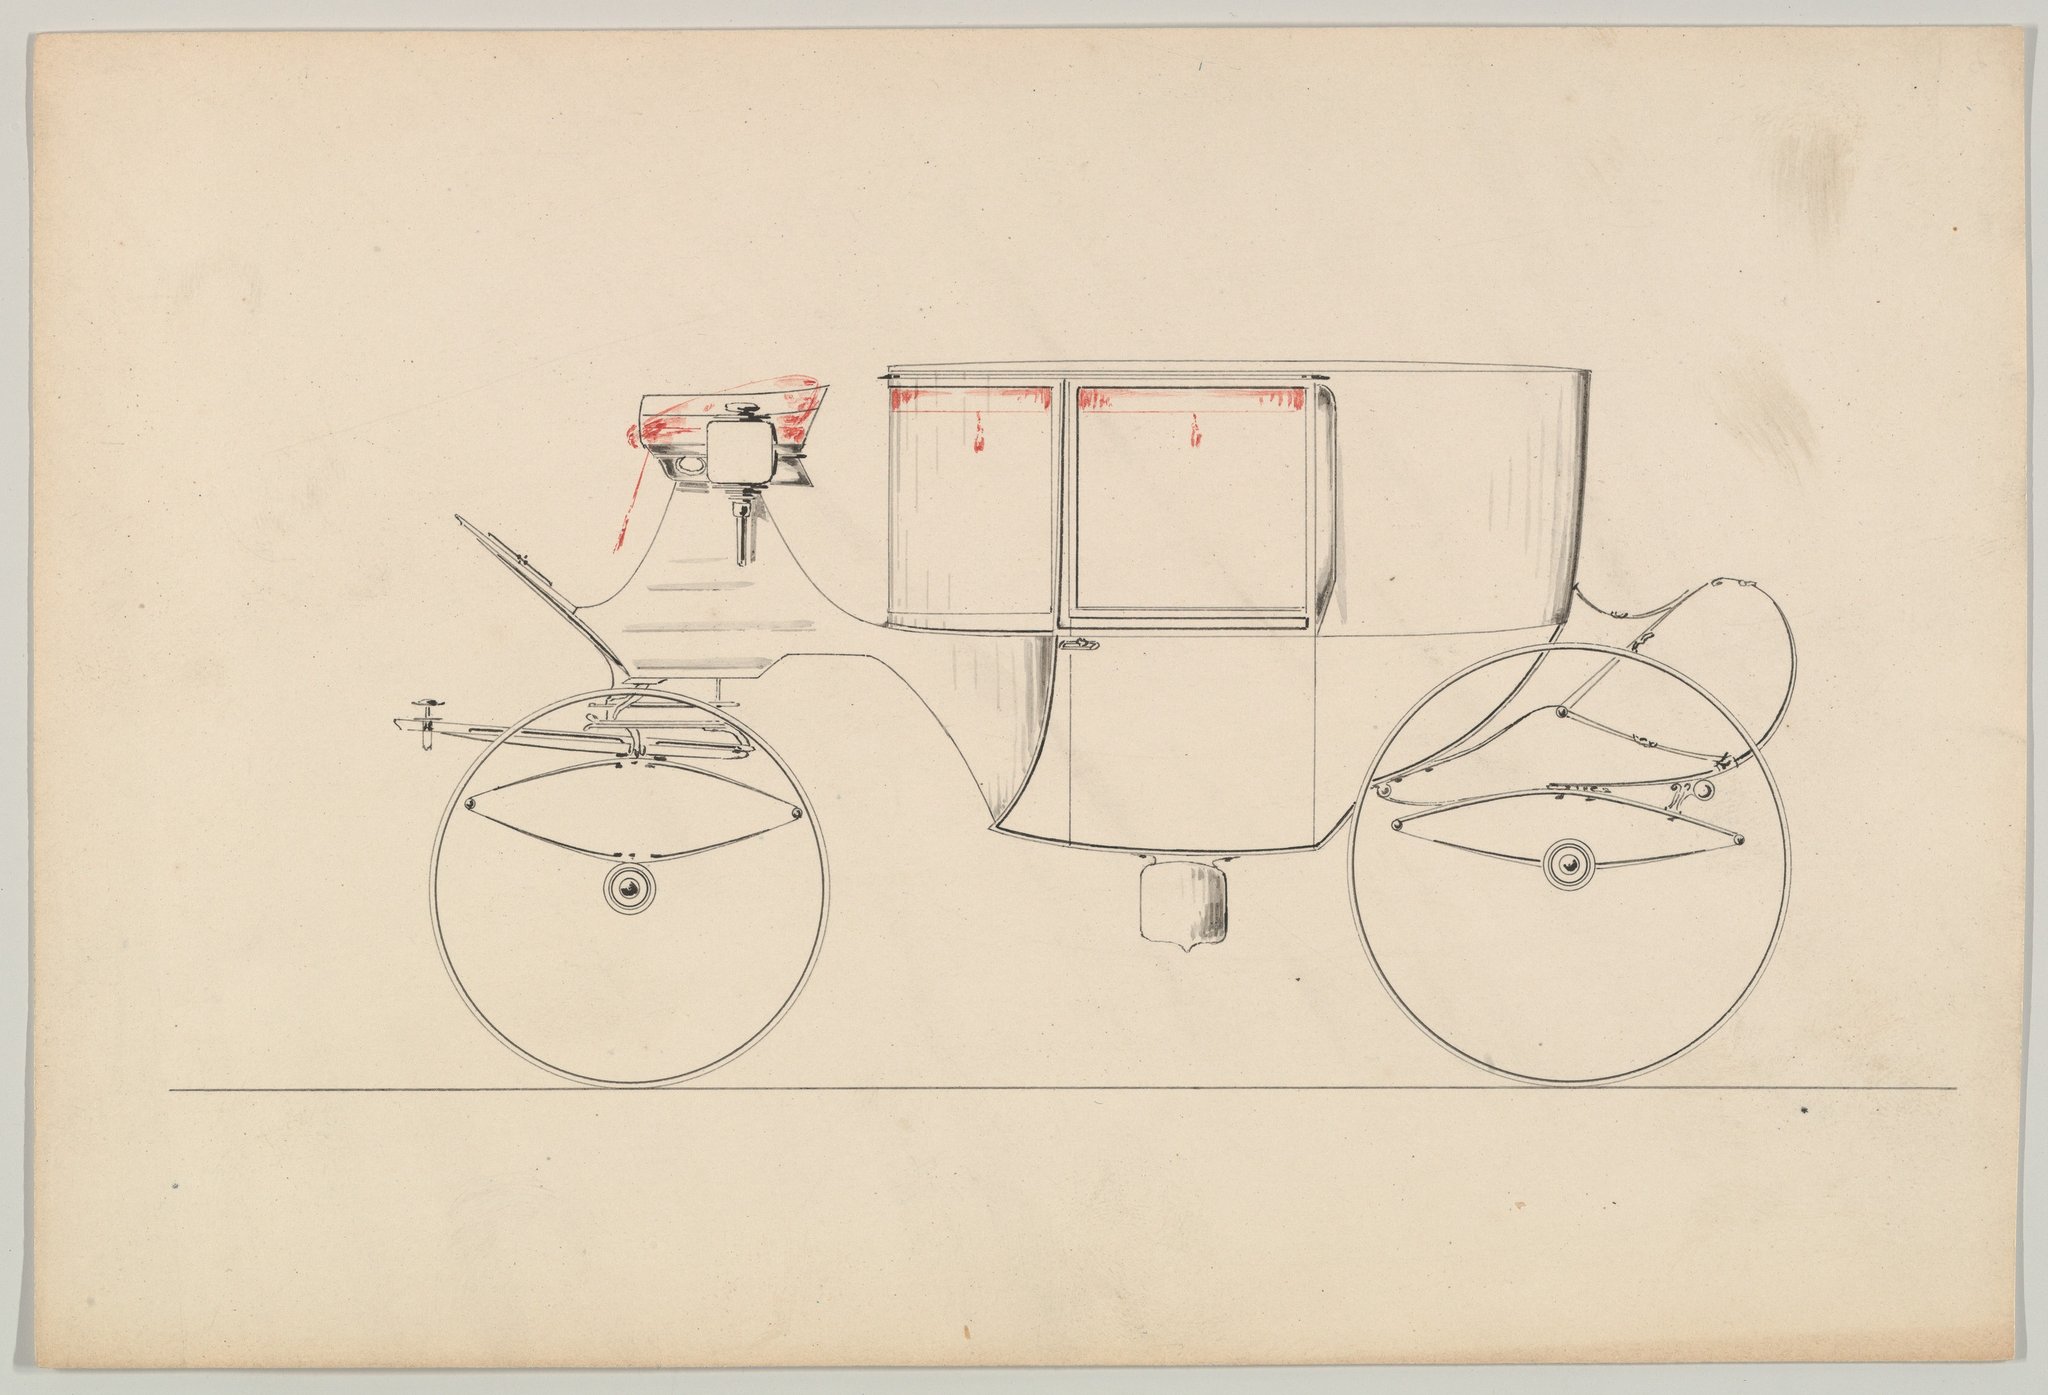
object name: drawing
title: Clarence (unnumbered)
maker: brewster & co.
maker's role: manufacturer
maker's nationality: american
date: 1850-1870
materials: gouache, watercolor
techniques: pen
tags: carriages